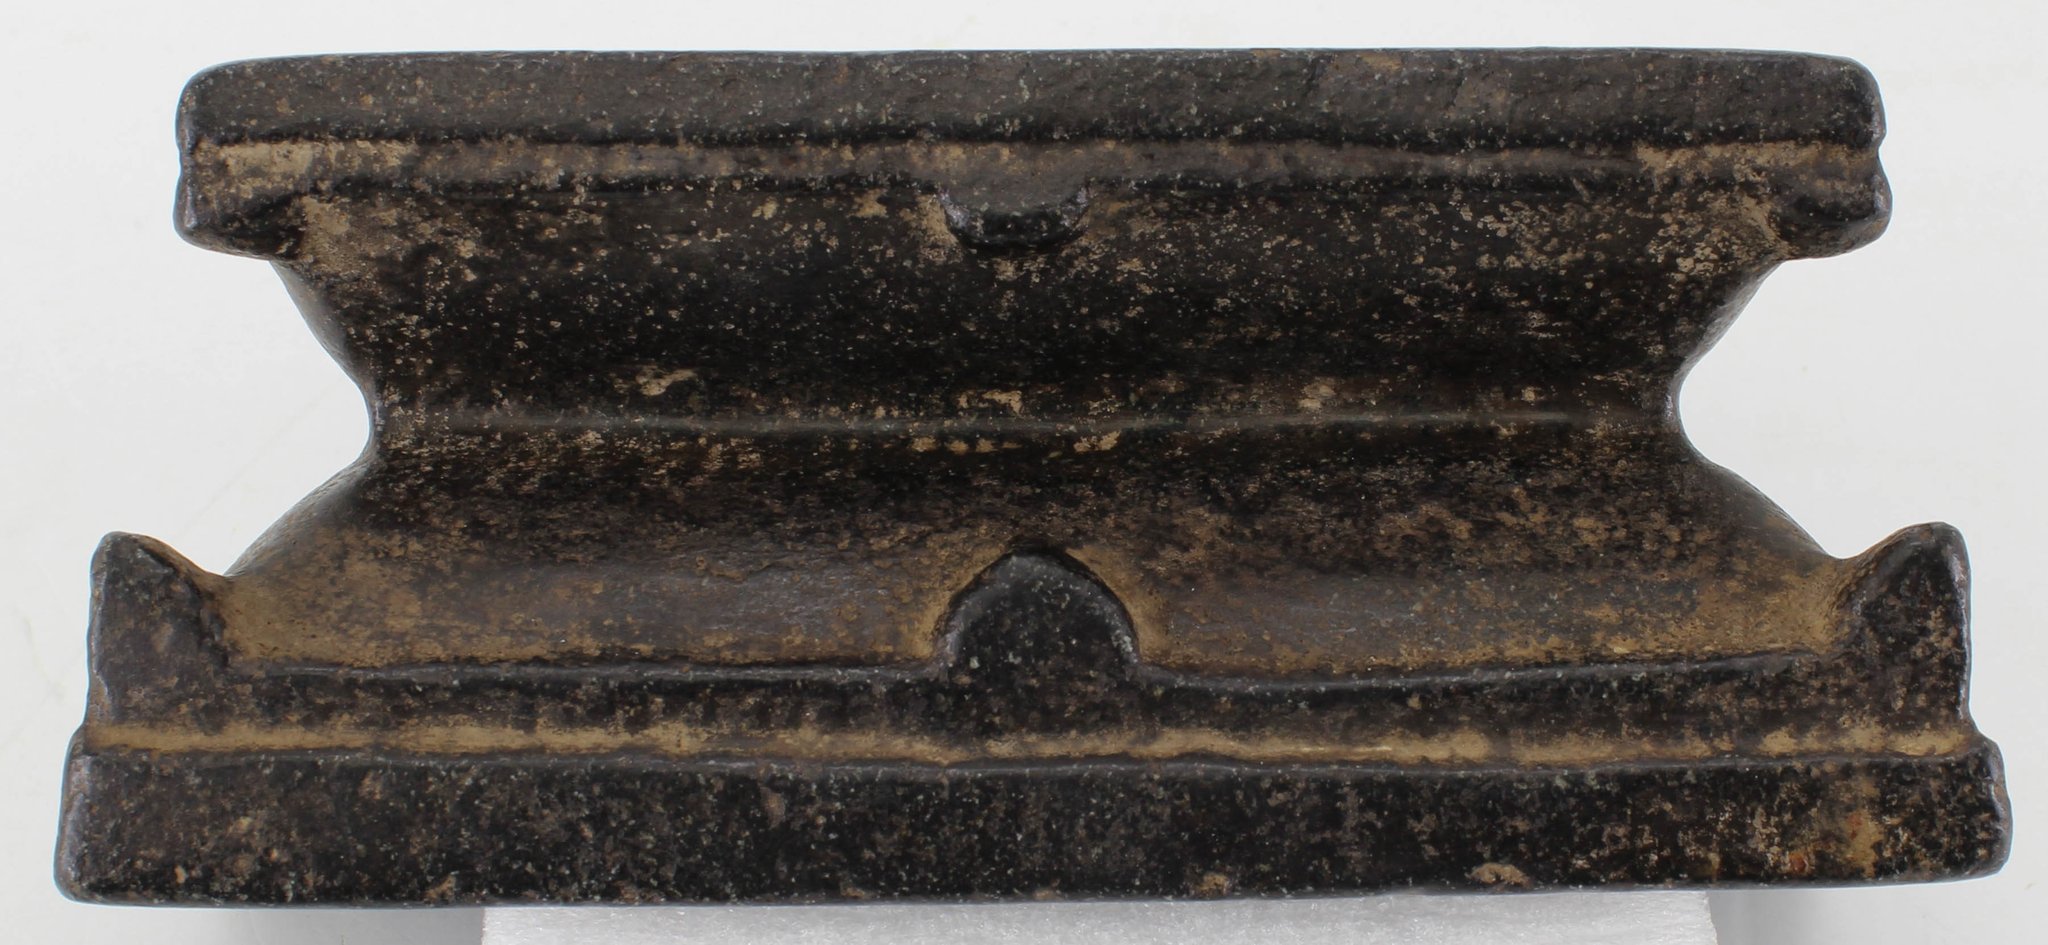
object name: mortar and pestle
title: Double-Sided Mortar and Pestle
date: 1601-1700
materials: stone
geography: india